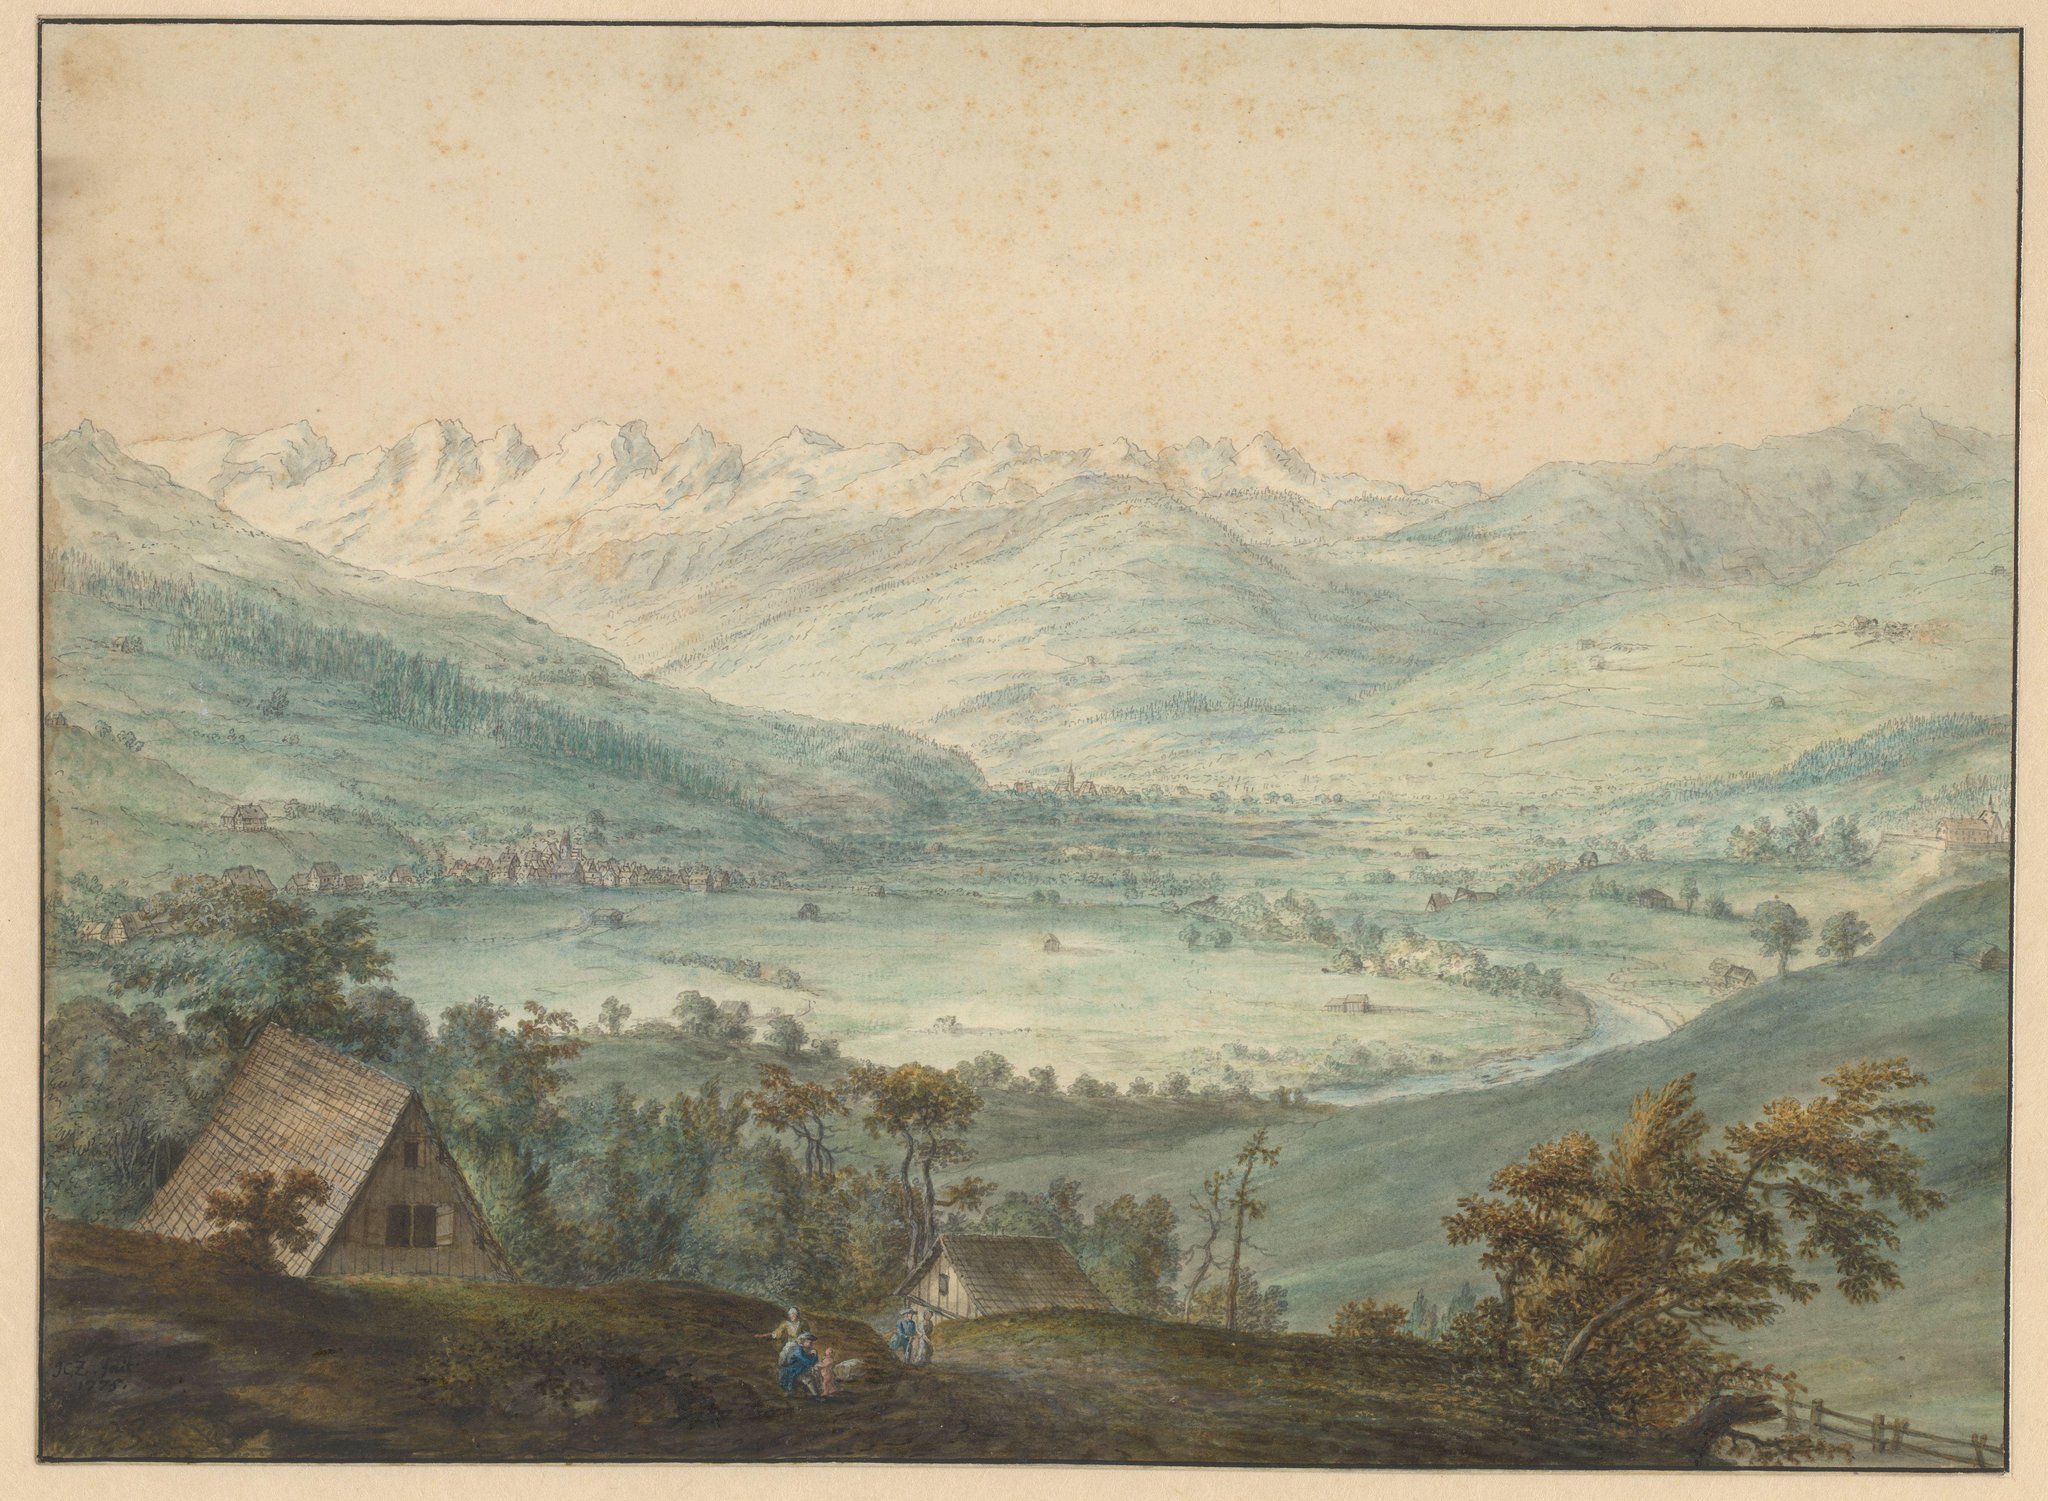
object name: drawing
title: Vallei van een rivier met dorpen en bergen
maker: j.c. zick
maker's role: draughtsman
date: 1775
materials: ink, paper, watercolor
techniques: brush, pen